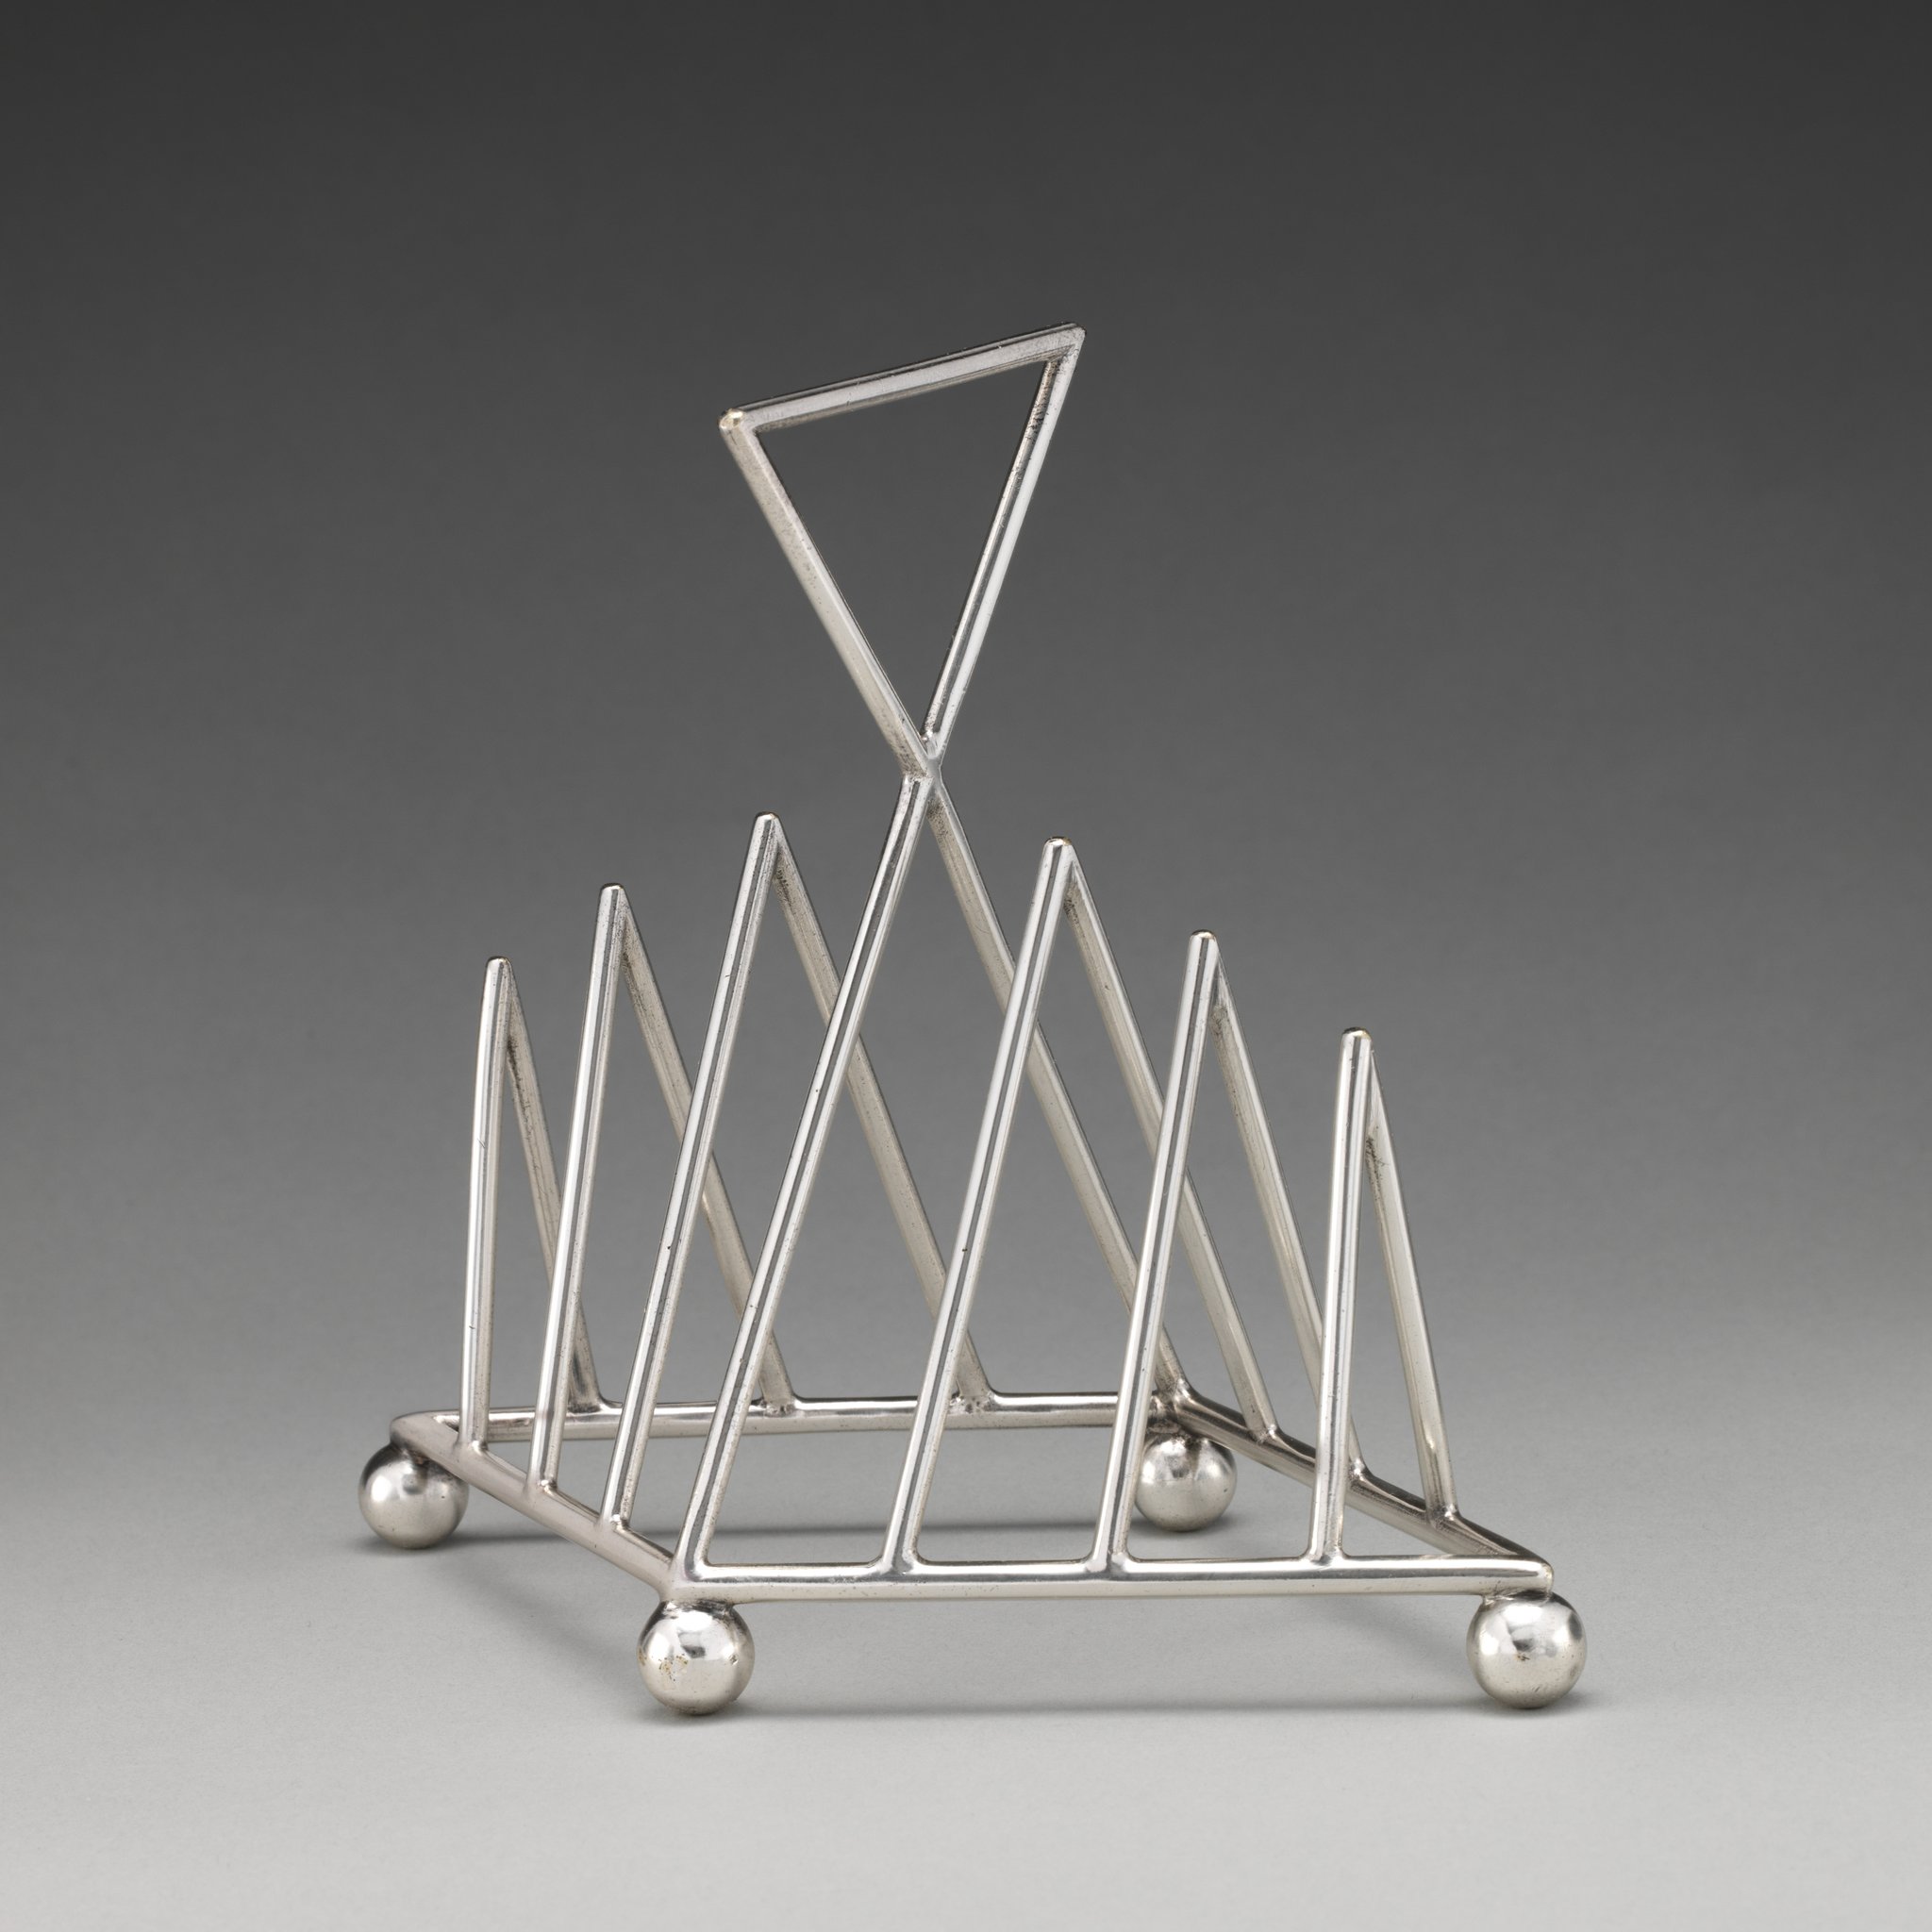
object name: toast rack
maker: christopher dresser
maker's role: designer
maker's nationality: british, scottish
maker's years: 1834-1904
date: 1879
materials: silver